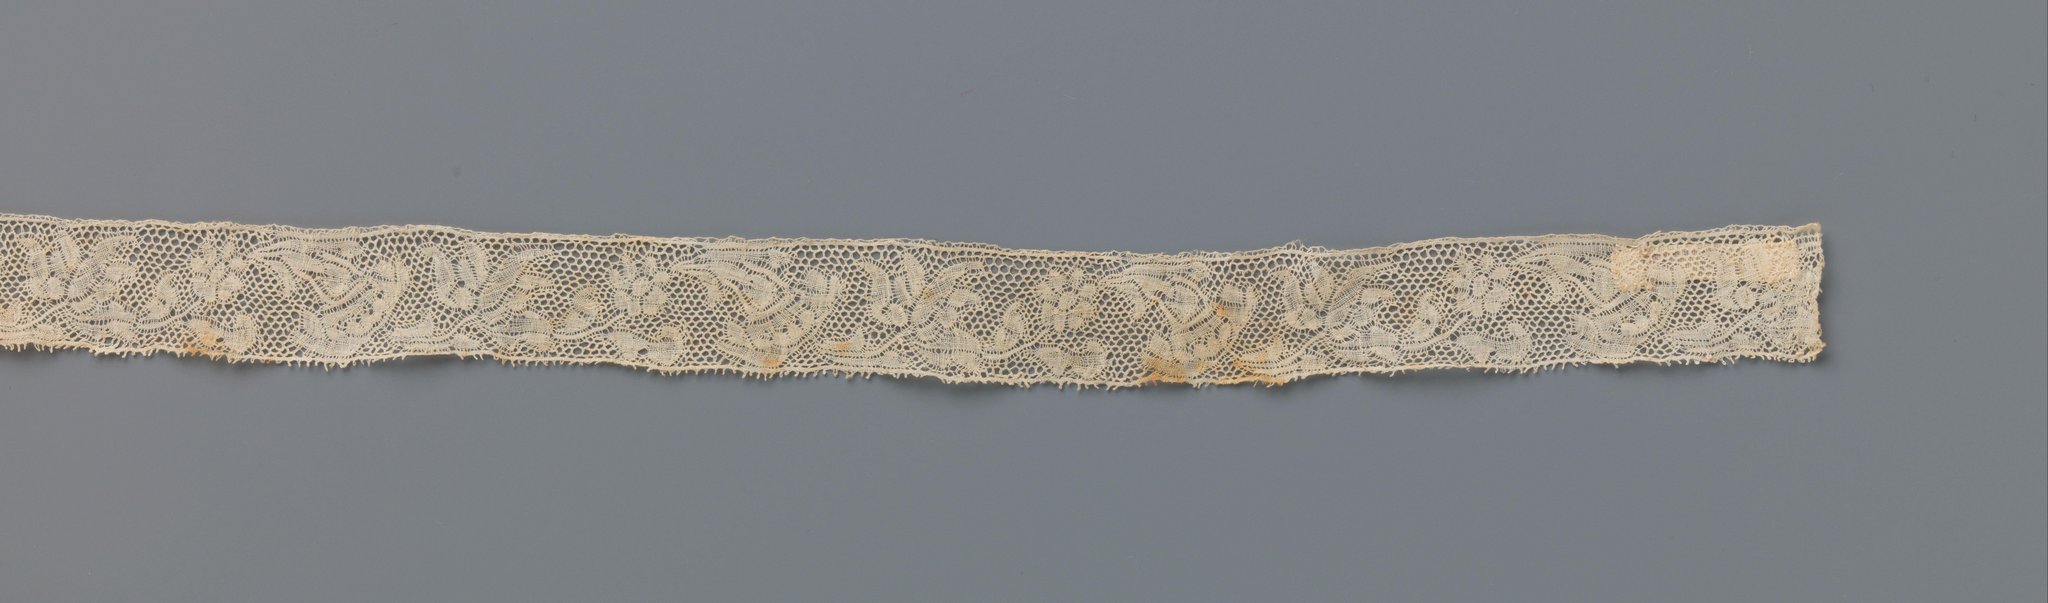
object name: strip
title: Strook kloskant met golvende lijn van drie verschillende bloemen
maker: Anonymous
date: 1790-1799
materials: linen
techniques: lace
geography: france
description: Strook naturelkleurige kloskant: Valenciennes-kant. Het zich herhalende en doorlopende patroon bestaat uit een aaneenschakeling van steeds drie verschillende bloemen in een golvende lijn. Het zijn een kelkbloem, een rozetbloempje aan een gebogen steel met twee blaadjes en een wijd uitstaande bloem als een esdoornblad. De motieven zijn gemaakt in linnenslag met uitsparingen en opengewerkte randjes. De motieven zijn met elkaar verbonden door een traliegrond, de ronde Valenciennes-grond. Boven- en onderzijde zijn recht afgewerkt, waarbij de onderzijde is voorzien van picots.